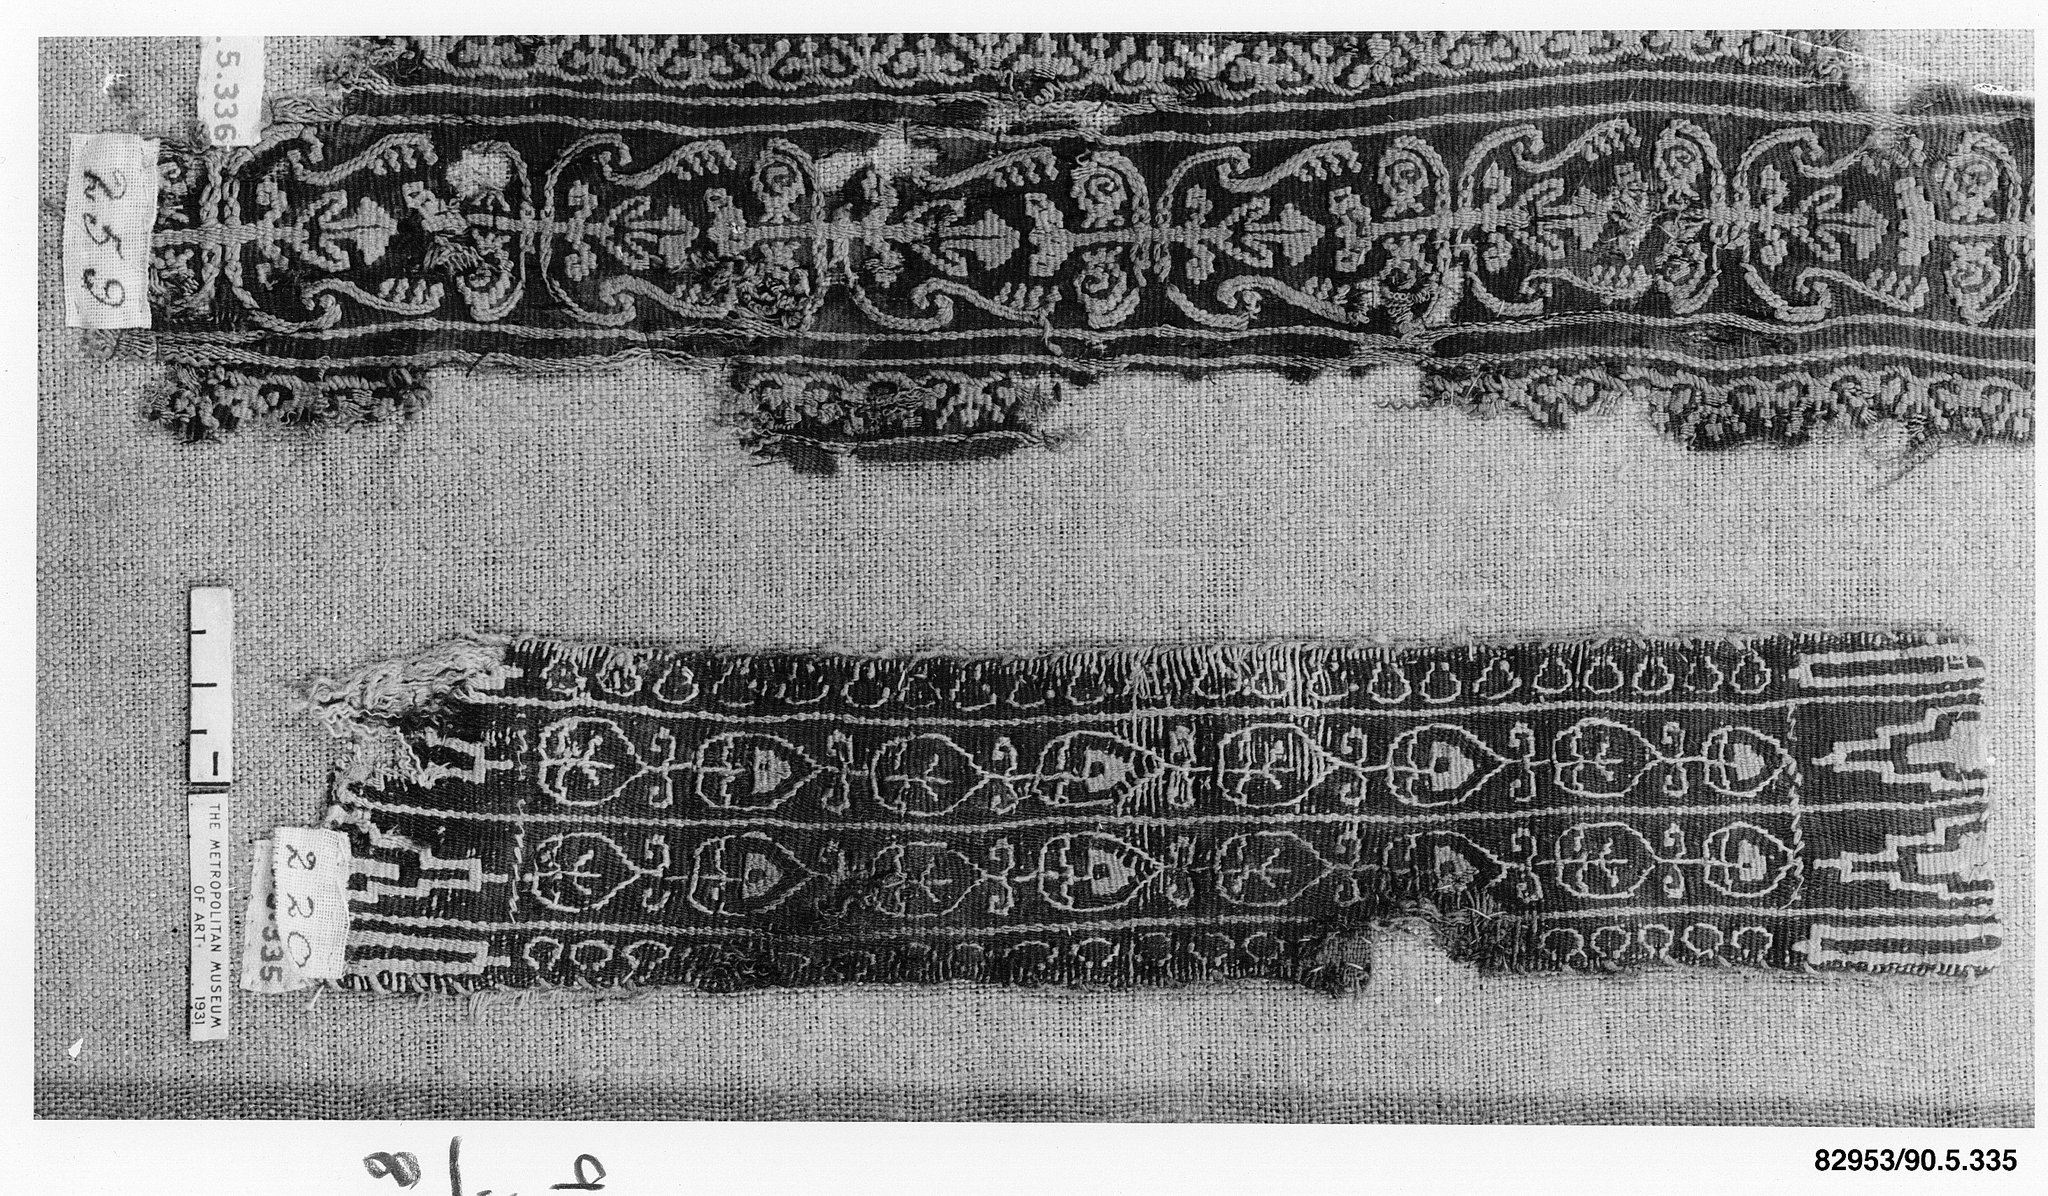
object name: textile fragment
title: Fragment of a Tunic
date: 401-500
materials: linen, wool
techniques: weave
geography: egypt